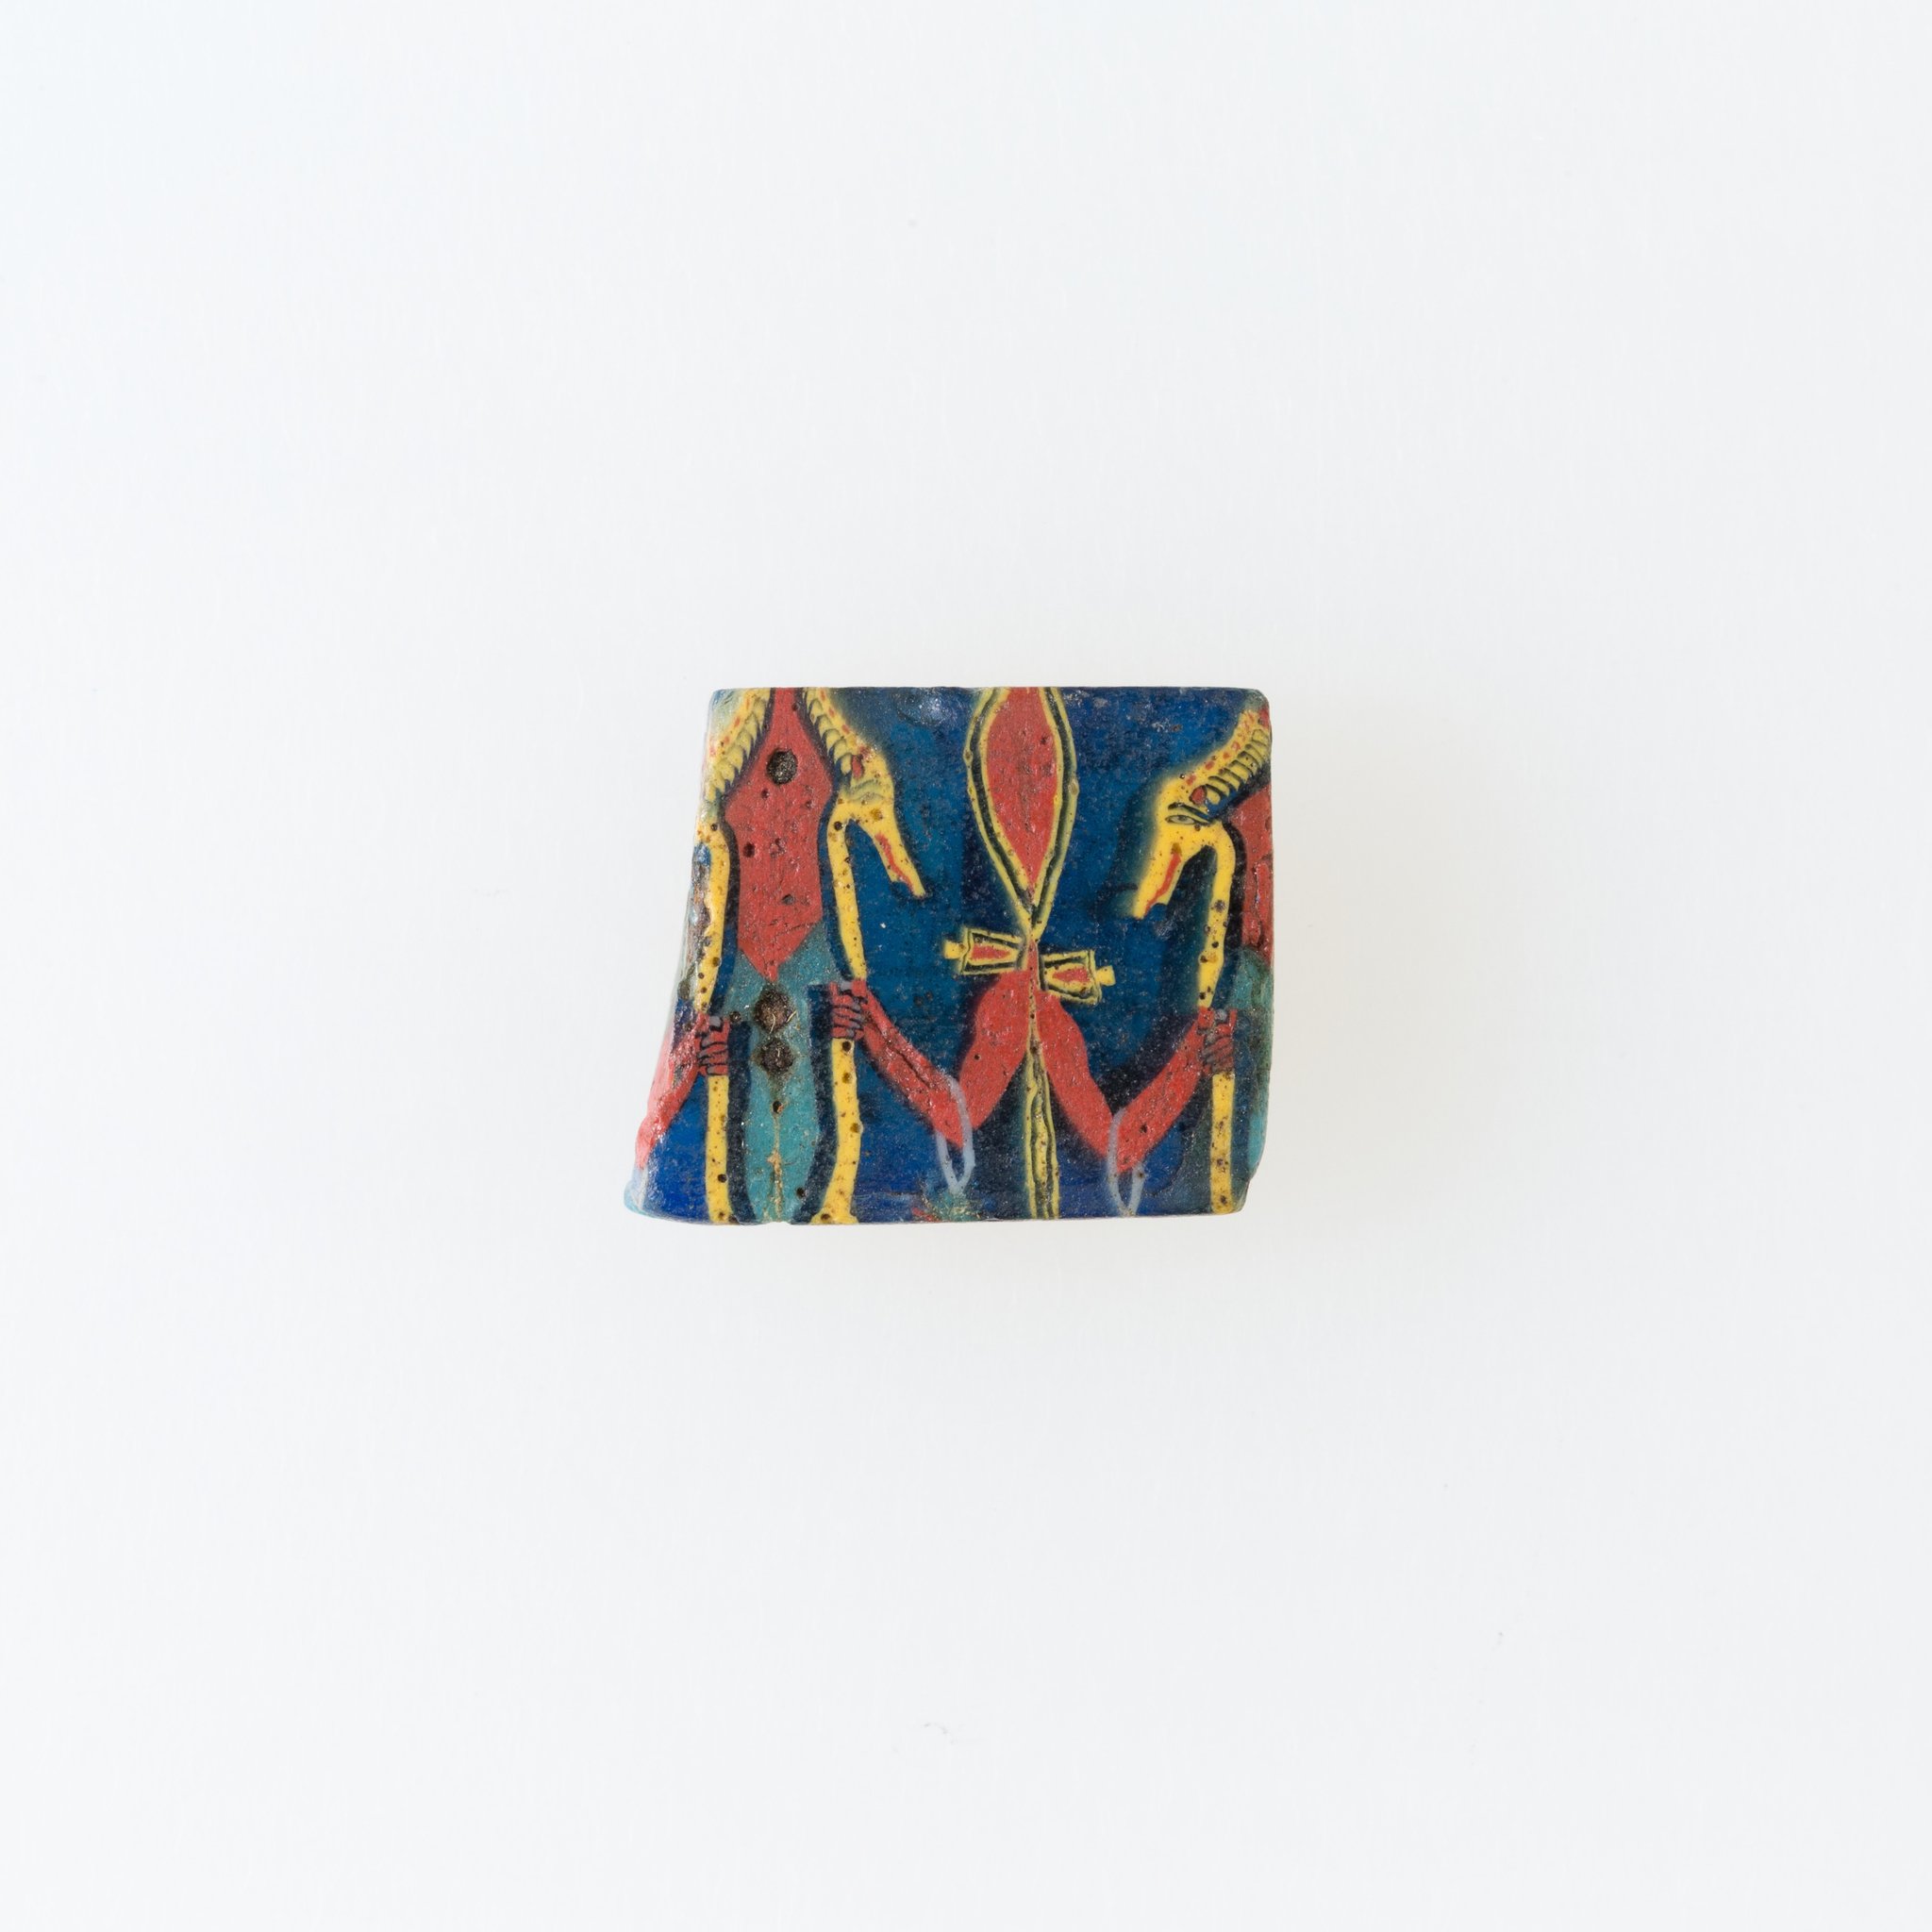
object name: inlay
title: Inlay, ankh with was scepters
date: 100 BCE-100 CE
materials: glass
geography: egypt